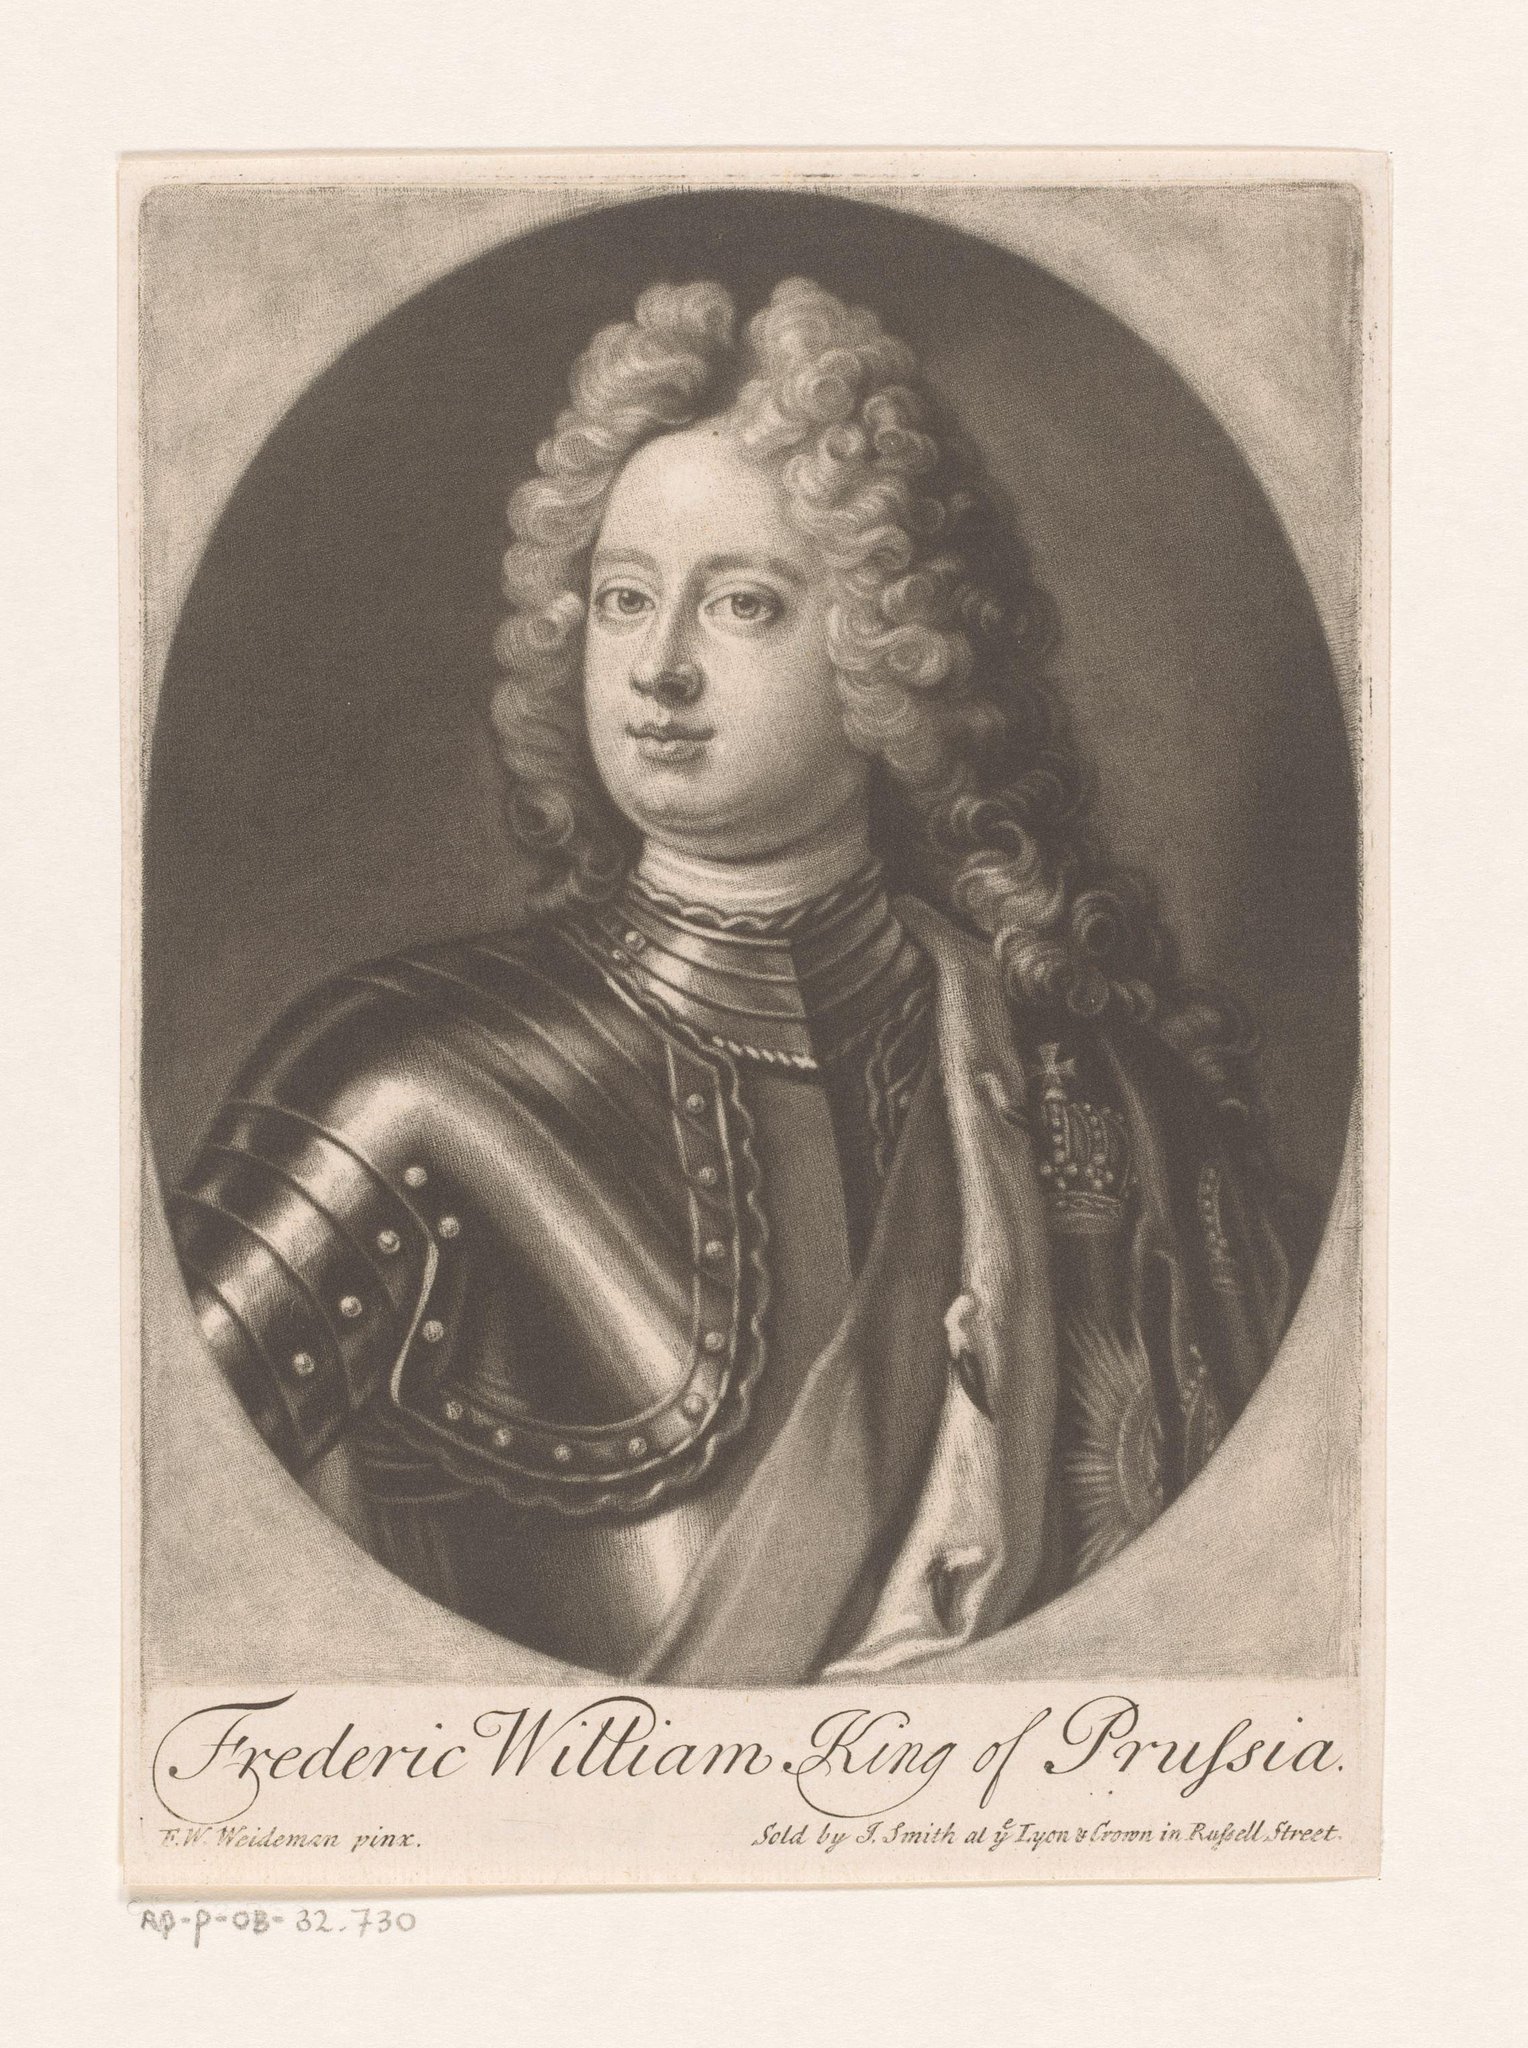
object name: print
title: Portret van Frederik Willem I, koning van Pruisen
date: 1689-1742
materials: paper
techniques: mezzotint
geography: london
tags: berlin, historical persons, king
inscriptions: collector's mark: Lugt 240